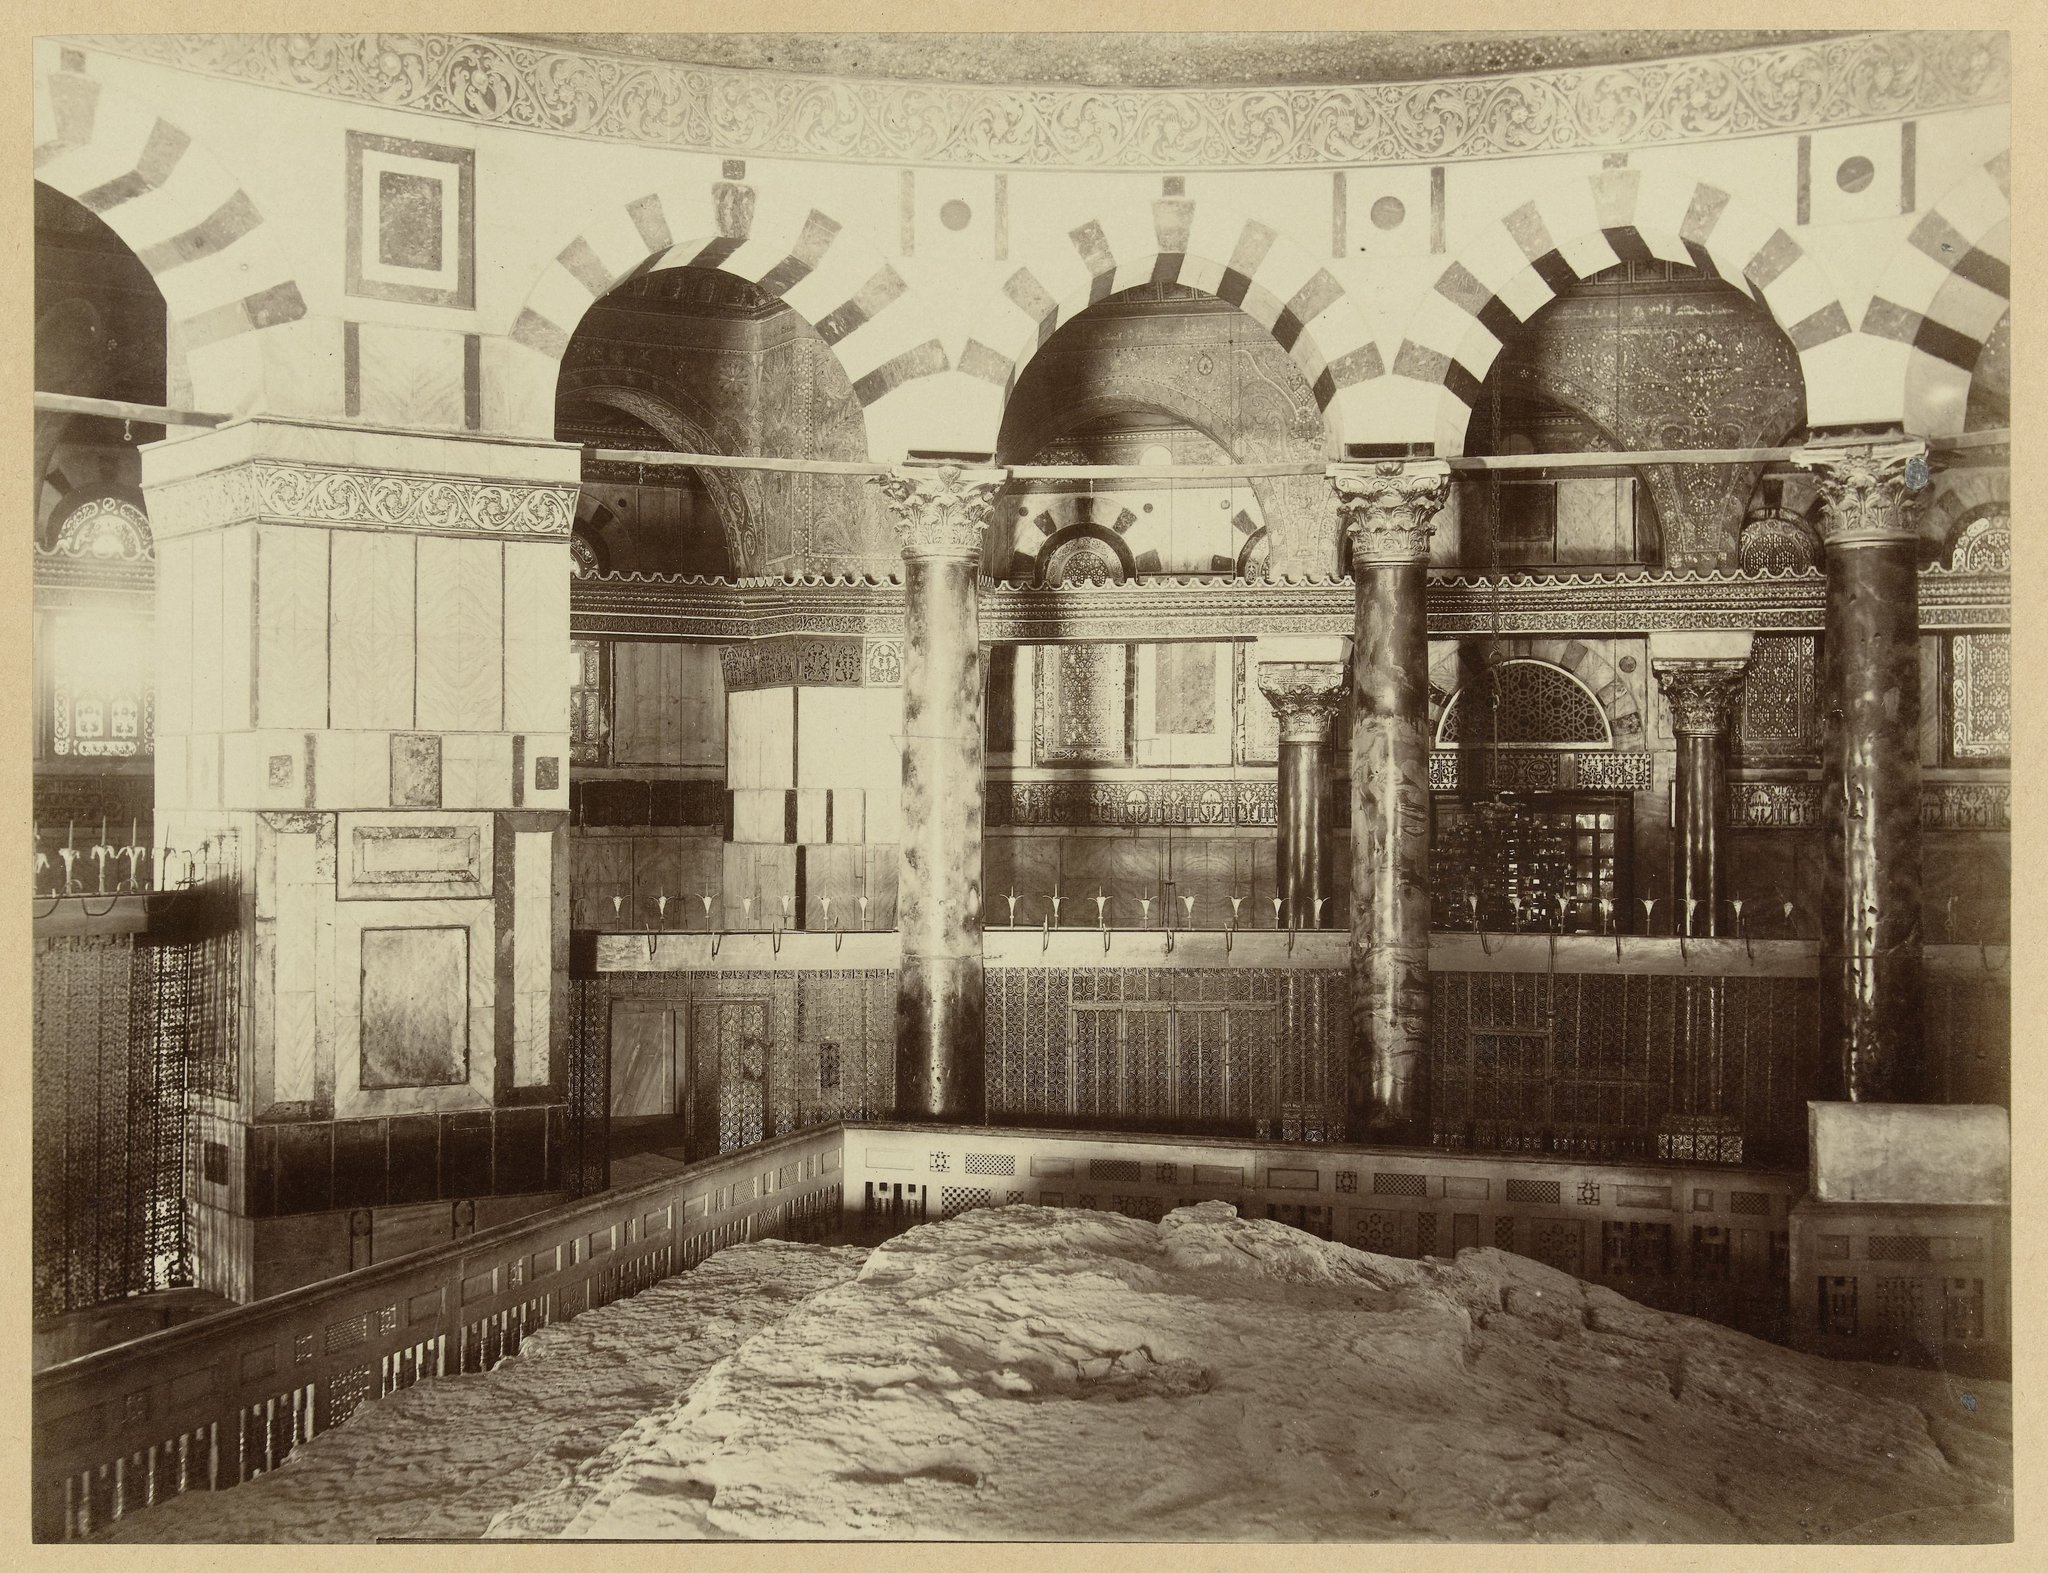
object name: photograph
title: S 19. De moskee van Omar (interieur)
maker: Anonymous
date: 1890-1895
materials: cardboard, paper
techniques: albumen print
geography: jerusalem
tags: temple, shrine ~ islam, mohammedanism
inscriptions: inscription: ‘S 19. De moskee van Omar (interieur)./ De kale rots is de plaats waar het offeraltaar zou hebben gestaan./ Jeruzalem.’, stamp: ‘Gemeentelijke bibliotheek/ Rotterdam’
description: Onderdeel van een groep door fotograaf Richard Polak op reis verzamelde foto’s. Deze foto is samen met andere op zijn reizen verzamelde foto's tentoongesteld bij de Rotterdamsche Kunstkring (1895), Arti en Amicitiae te Amsterdam (1897-1898?) en Societeit 't Collegie te Kampen (datum vooralsnog onbekend).